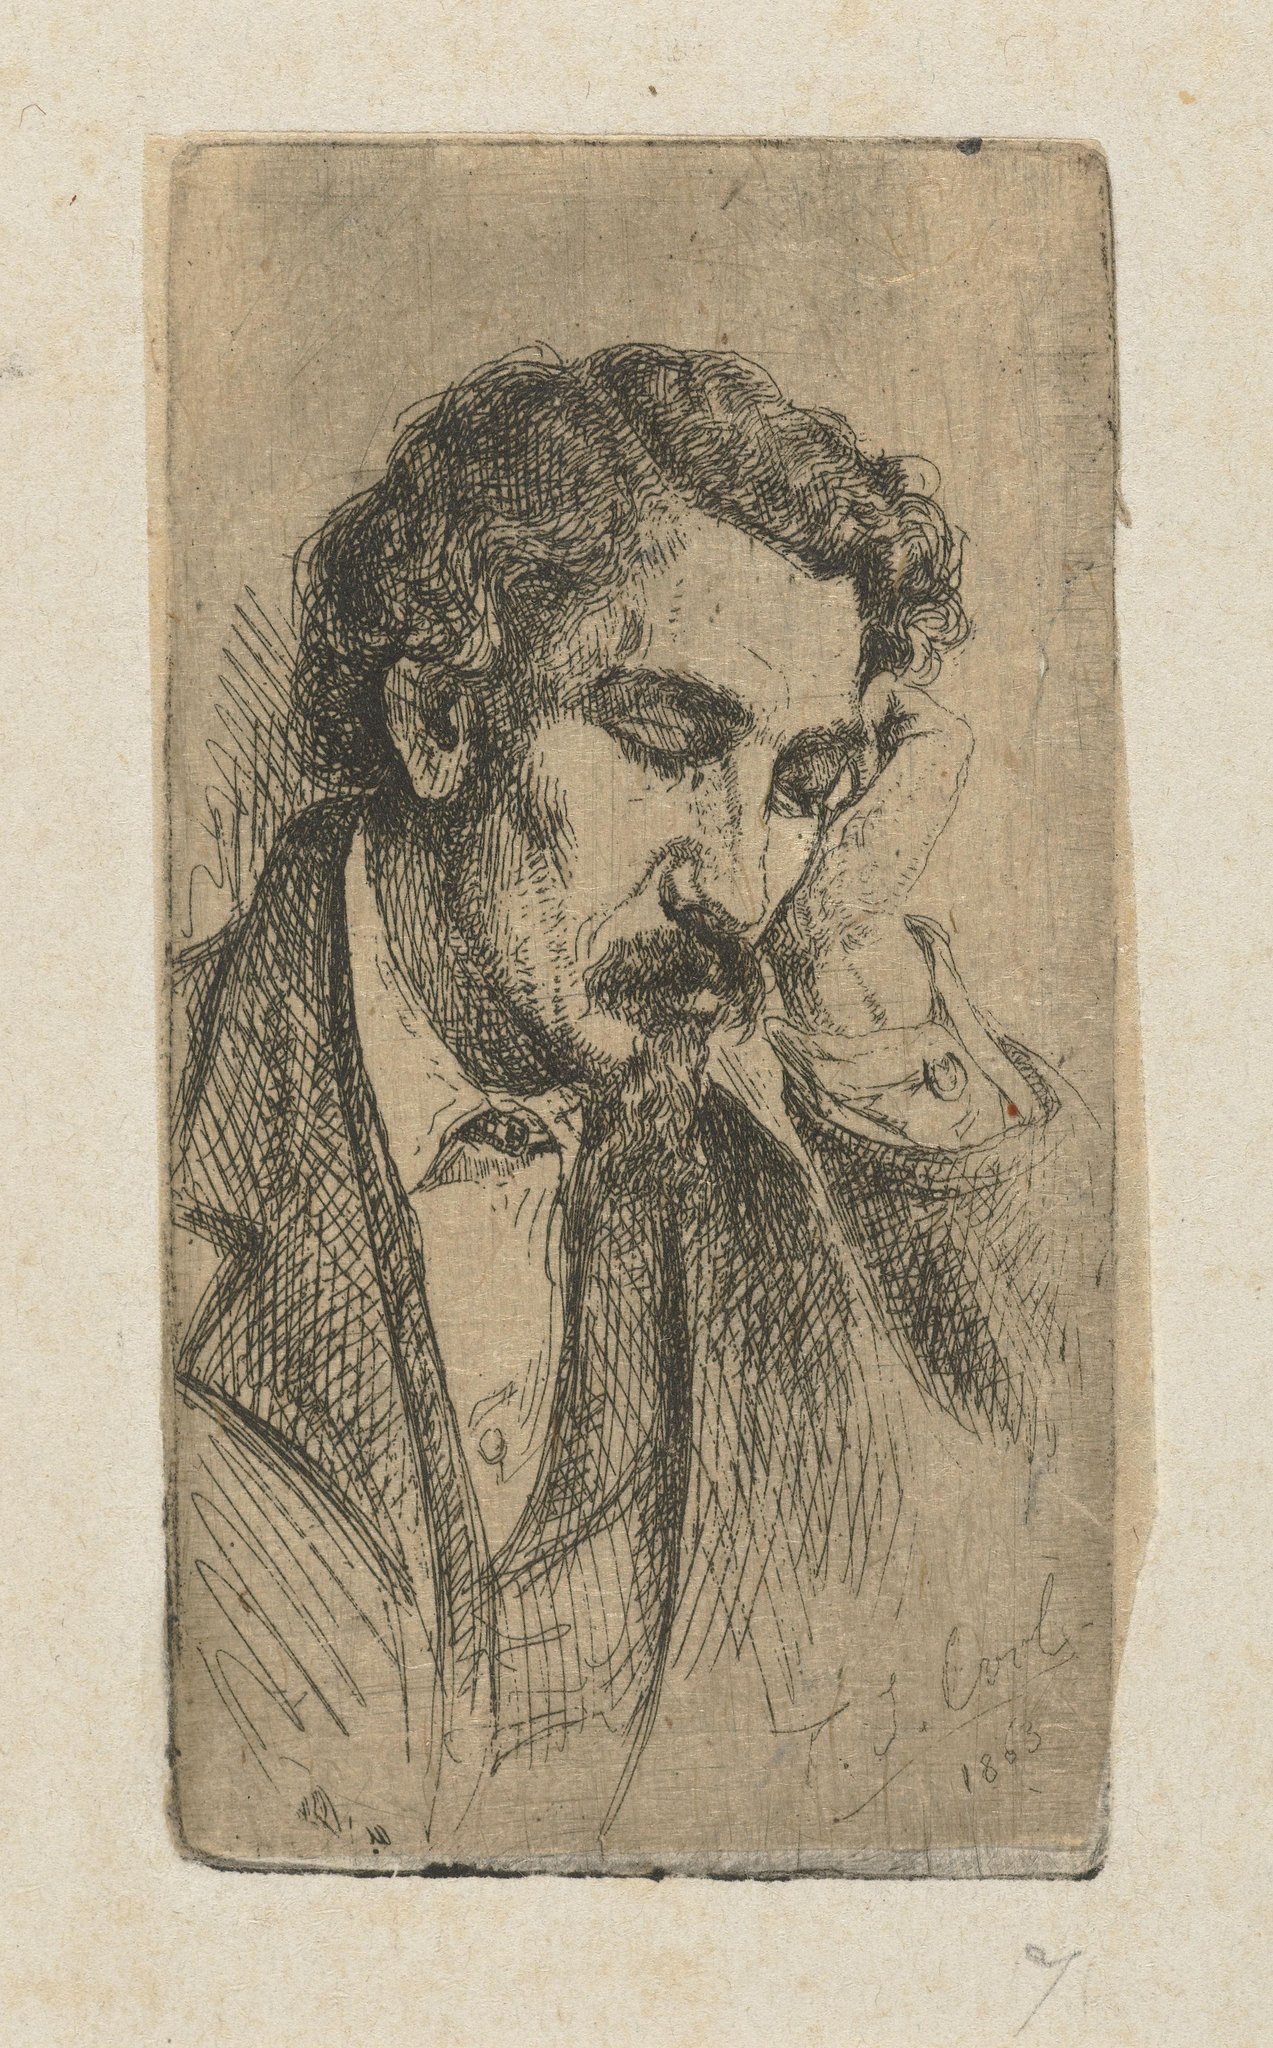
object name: print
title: Portret van de schilder Taco Scheltema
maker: thomas simon cool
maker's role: draughtsman, print maker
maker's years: 1831-1870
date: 1863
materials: paper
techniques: etching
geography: netherlands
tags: arnhem, the hague, draughtsman, taco jan scheltema